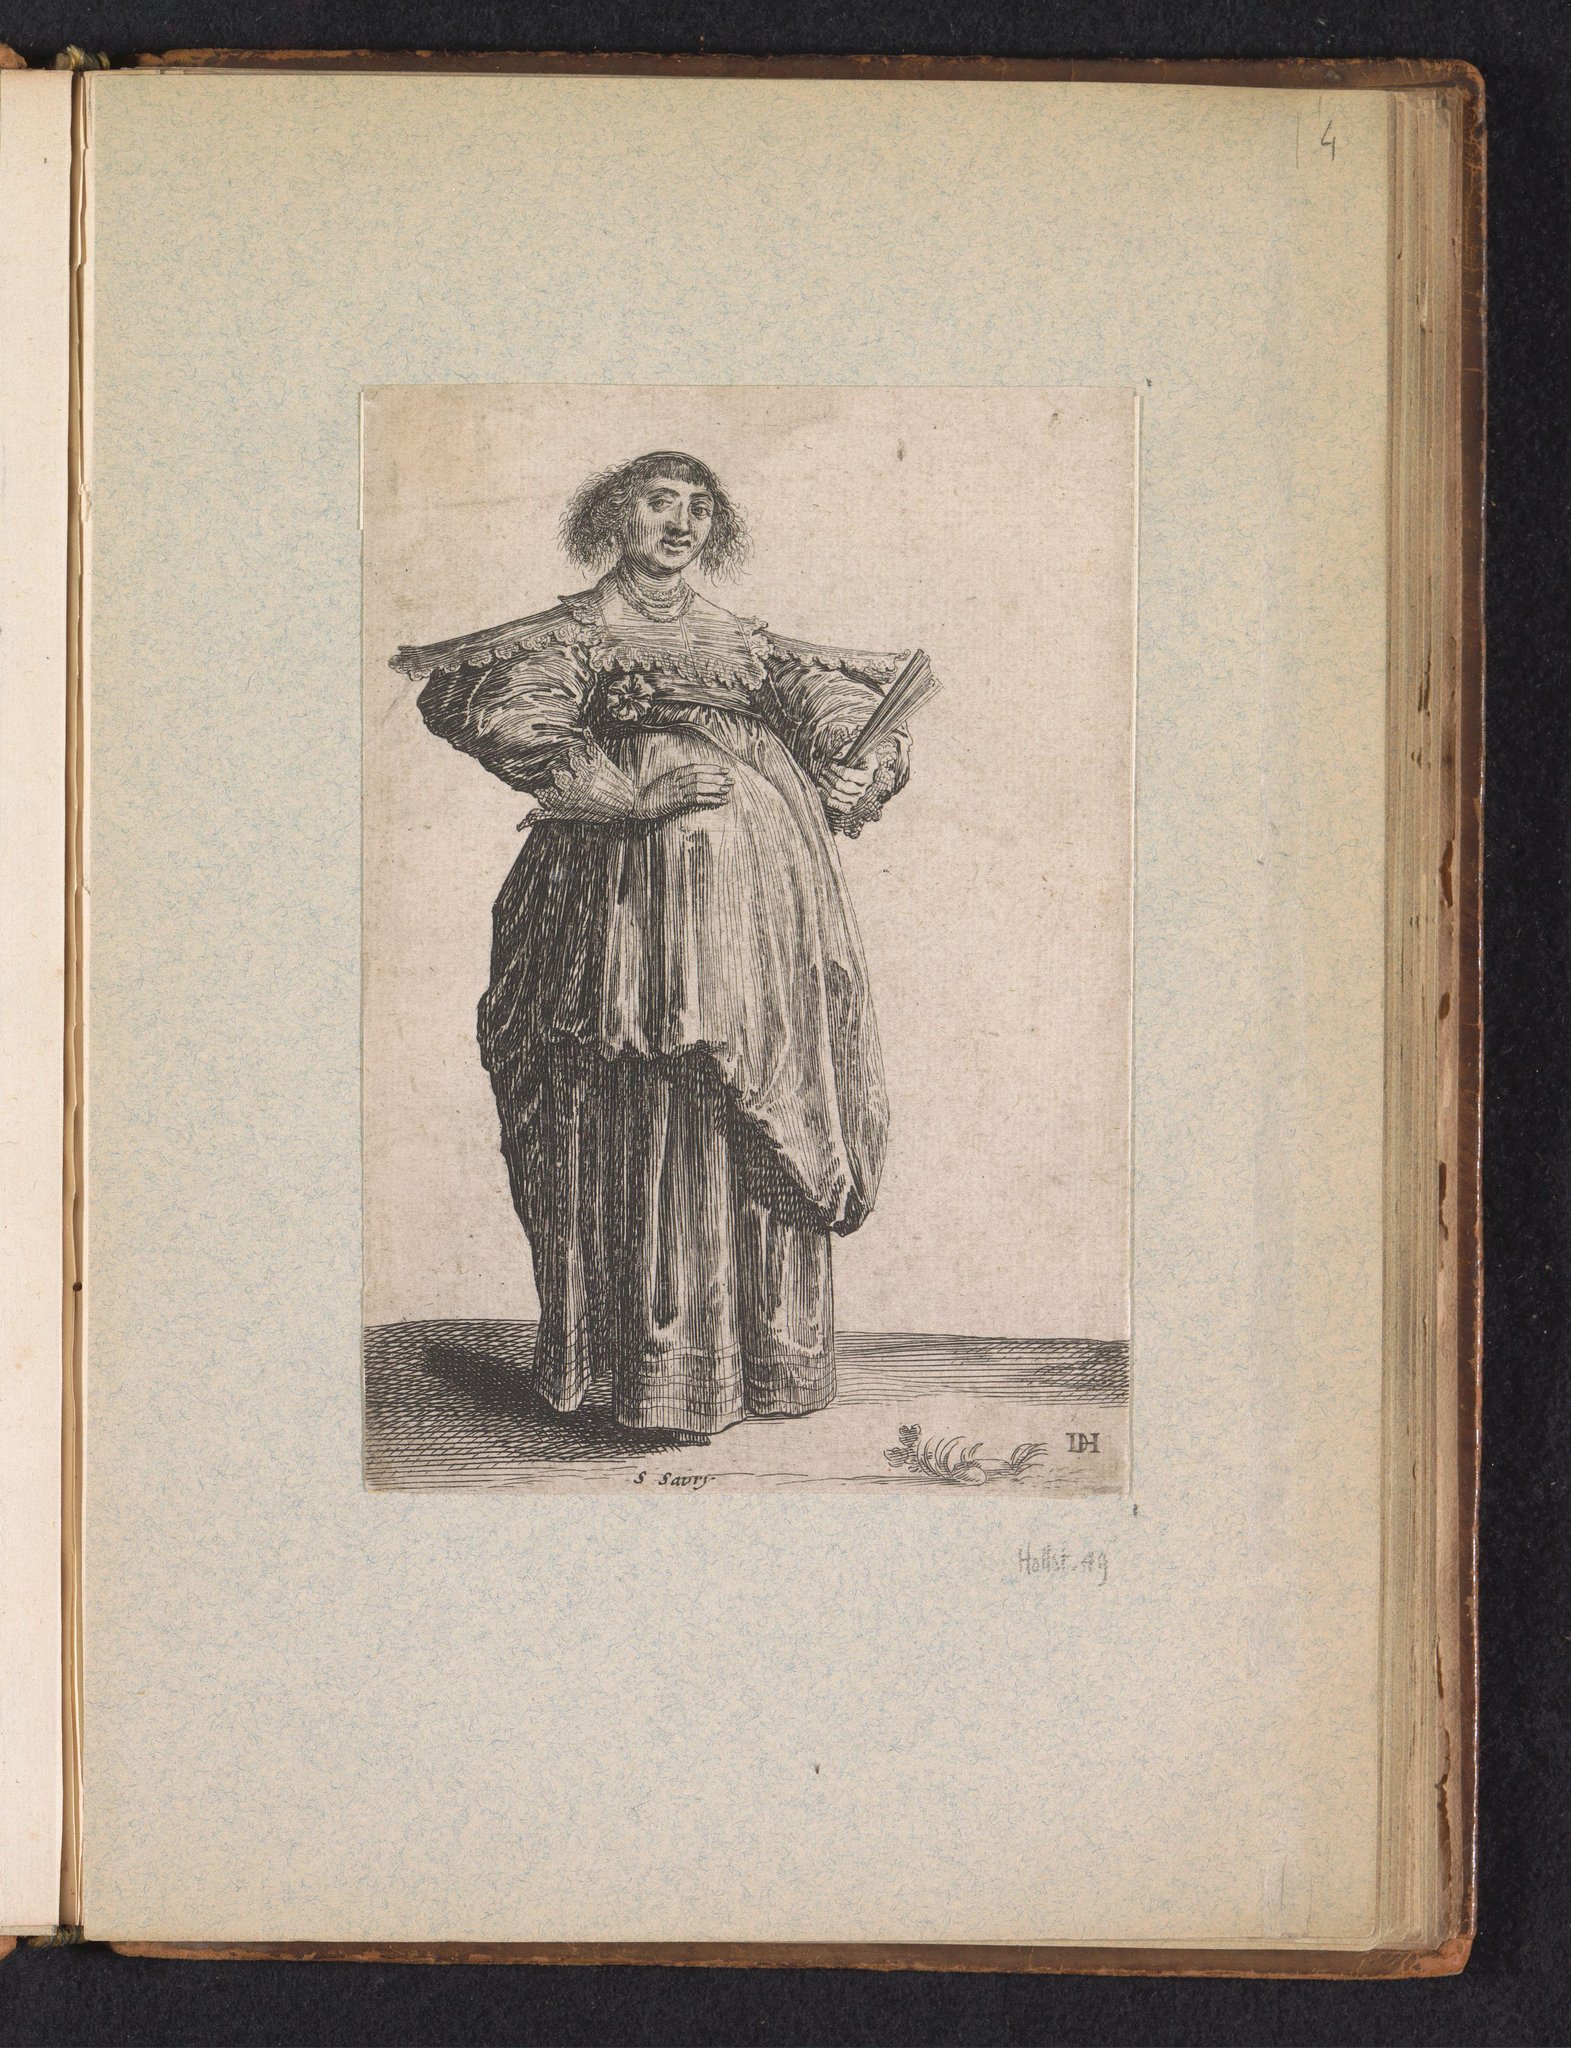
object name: album leaf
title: Vrouw, gekleed volgens de mode omstreeks 1620, met gesloten waaier in de hand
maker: salomon savery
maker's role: print maker, publisher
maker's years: 1594-1683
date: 1620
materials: paper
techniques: etching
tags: neck-gear: collar (+ women's clothes), clothes, costume (+ women's clothes), skirt (+ women's clothes), sleeves: cuffs (+ women's clothes), dress, gown (+ women's clothes), fan (+ women's clothes), sleeves (+ women's clothes), necklace (+ women's clothes)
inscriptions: signature: ‘S. Savry’, monogram: ‘DH’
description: Vrouw, gekleed volgens de mode omstreeks 1620, staand, iets naar rechts gekeerd. In de linkerhand houdt ze een gesloten waaier, de rechterhand in de zij.